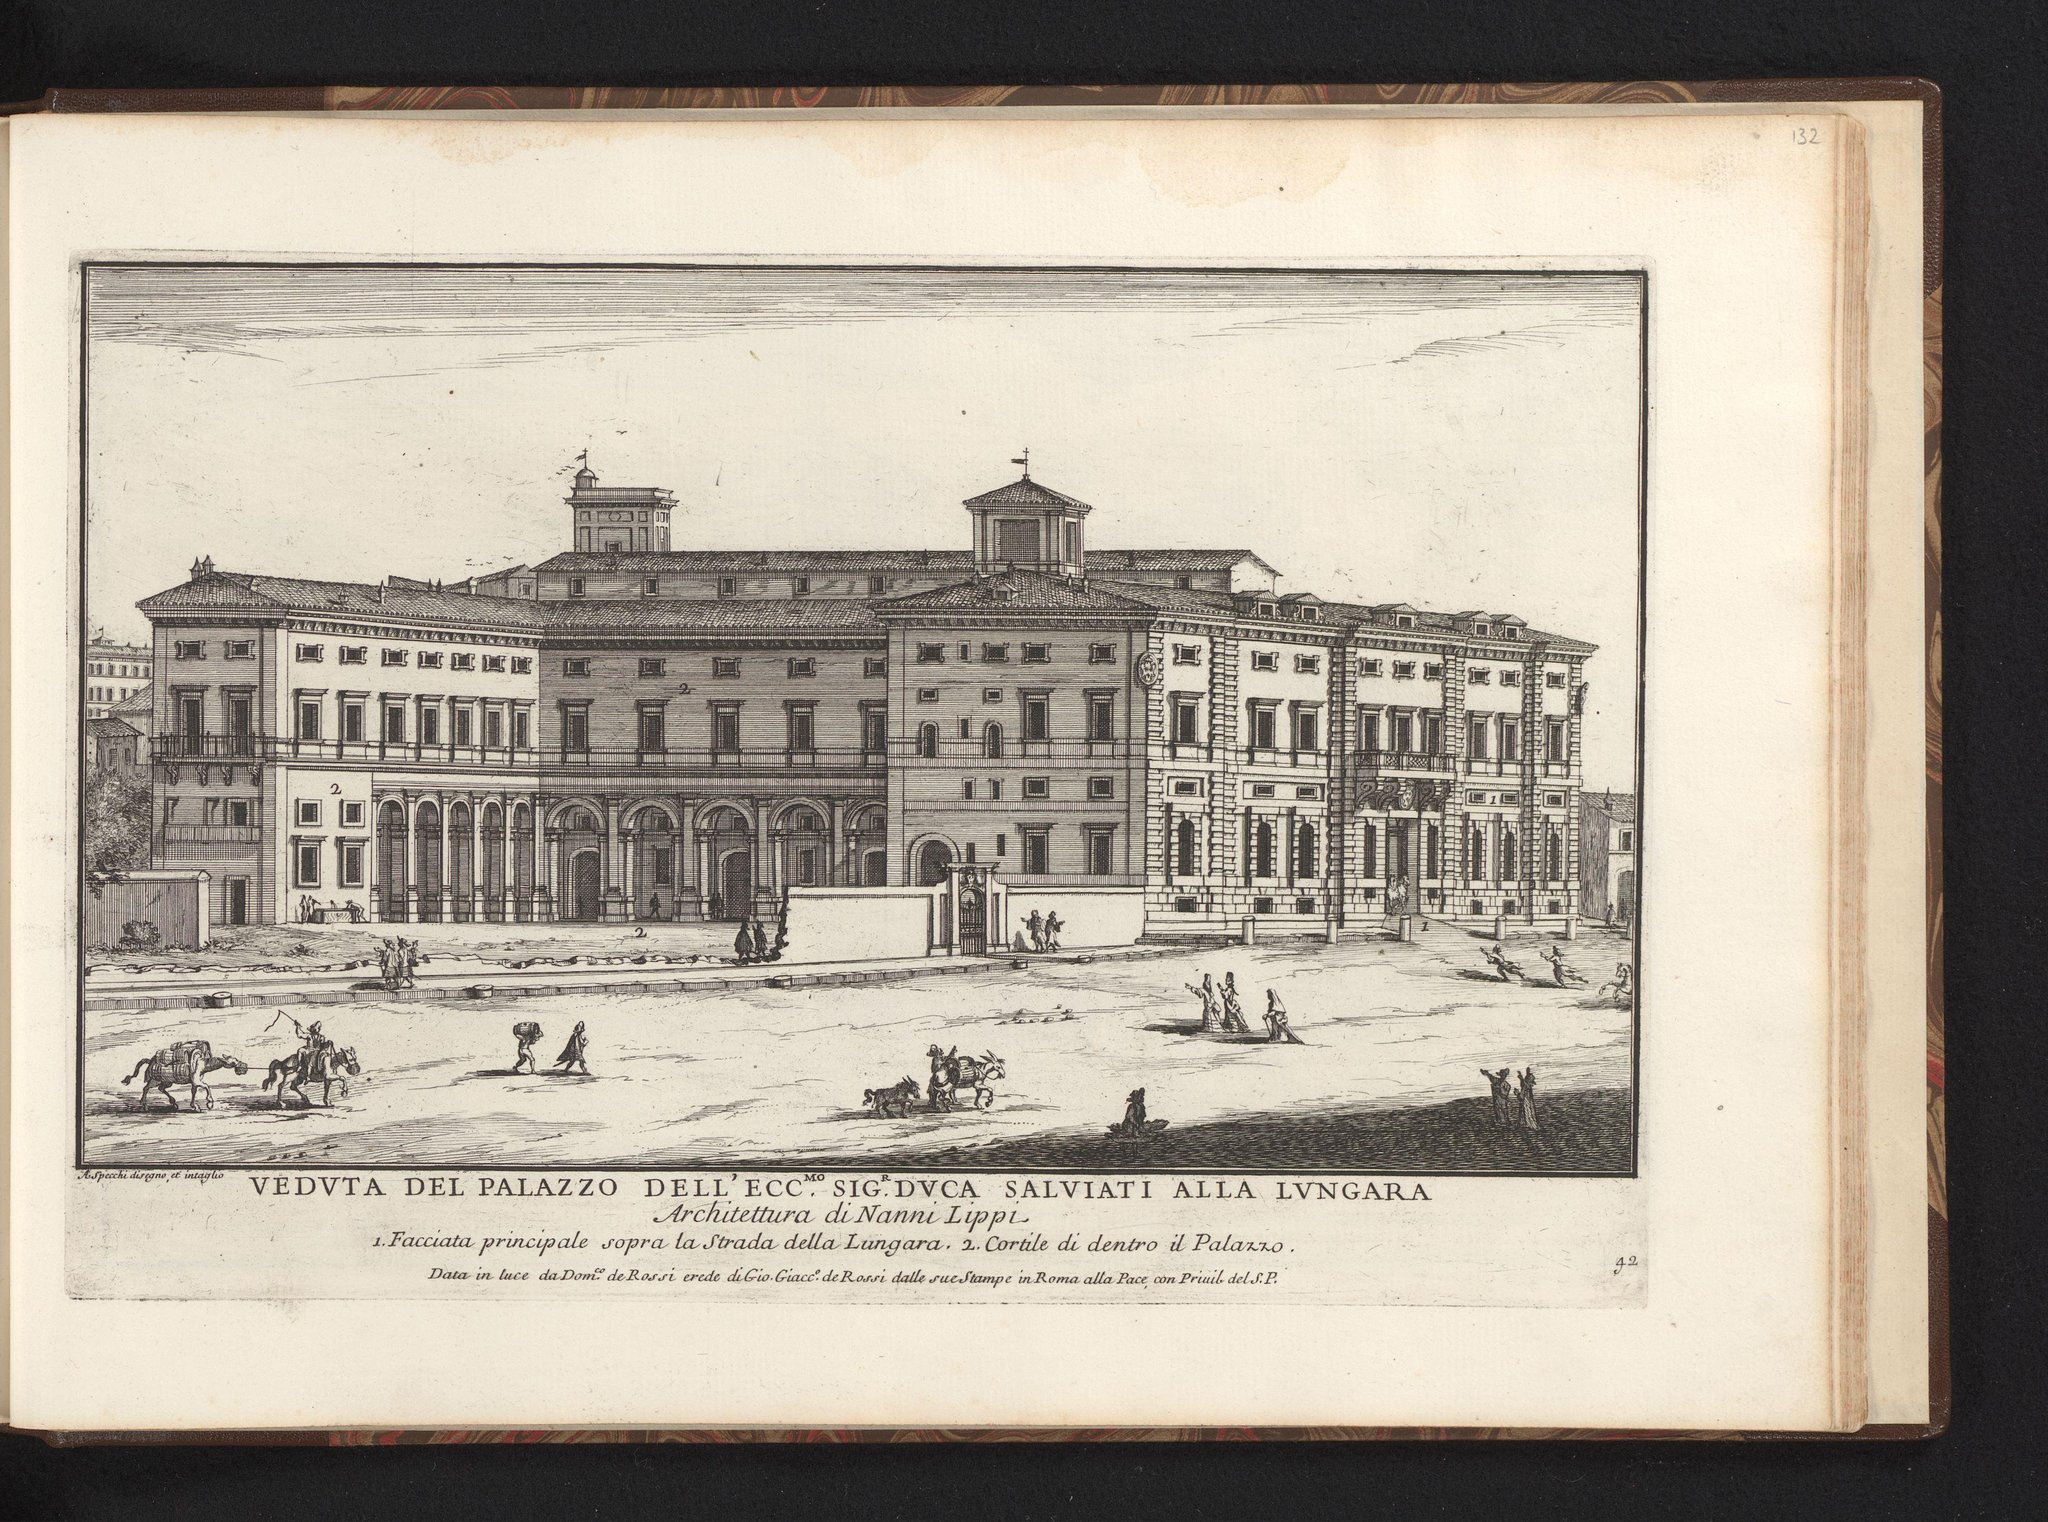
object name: album leaf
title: Il quarti libro del nuovo teatro delli palazzi in prospettiva di Roma moderna daton in luce sotto il felice pontificato de nostro signore papa Innocenzo XI (...) (libro quarto)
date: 1699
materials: paper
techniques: etching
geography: rome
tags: city-view, and landscape with man-made constructions, hôtel, i.e. small palace in city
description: Deze prent maakt deel uit van een reeks van 52 prenten met voorstellingen van paleizen in Rome. Samen met vier andere reeksen vormt het de grote reeks: 'Il nuovo teatro di Roma moderna'.